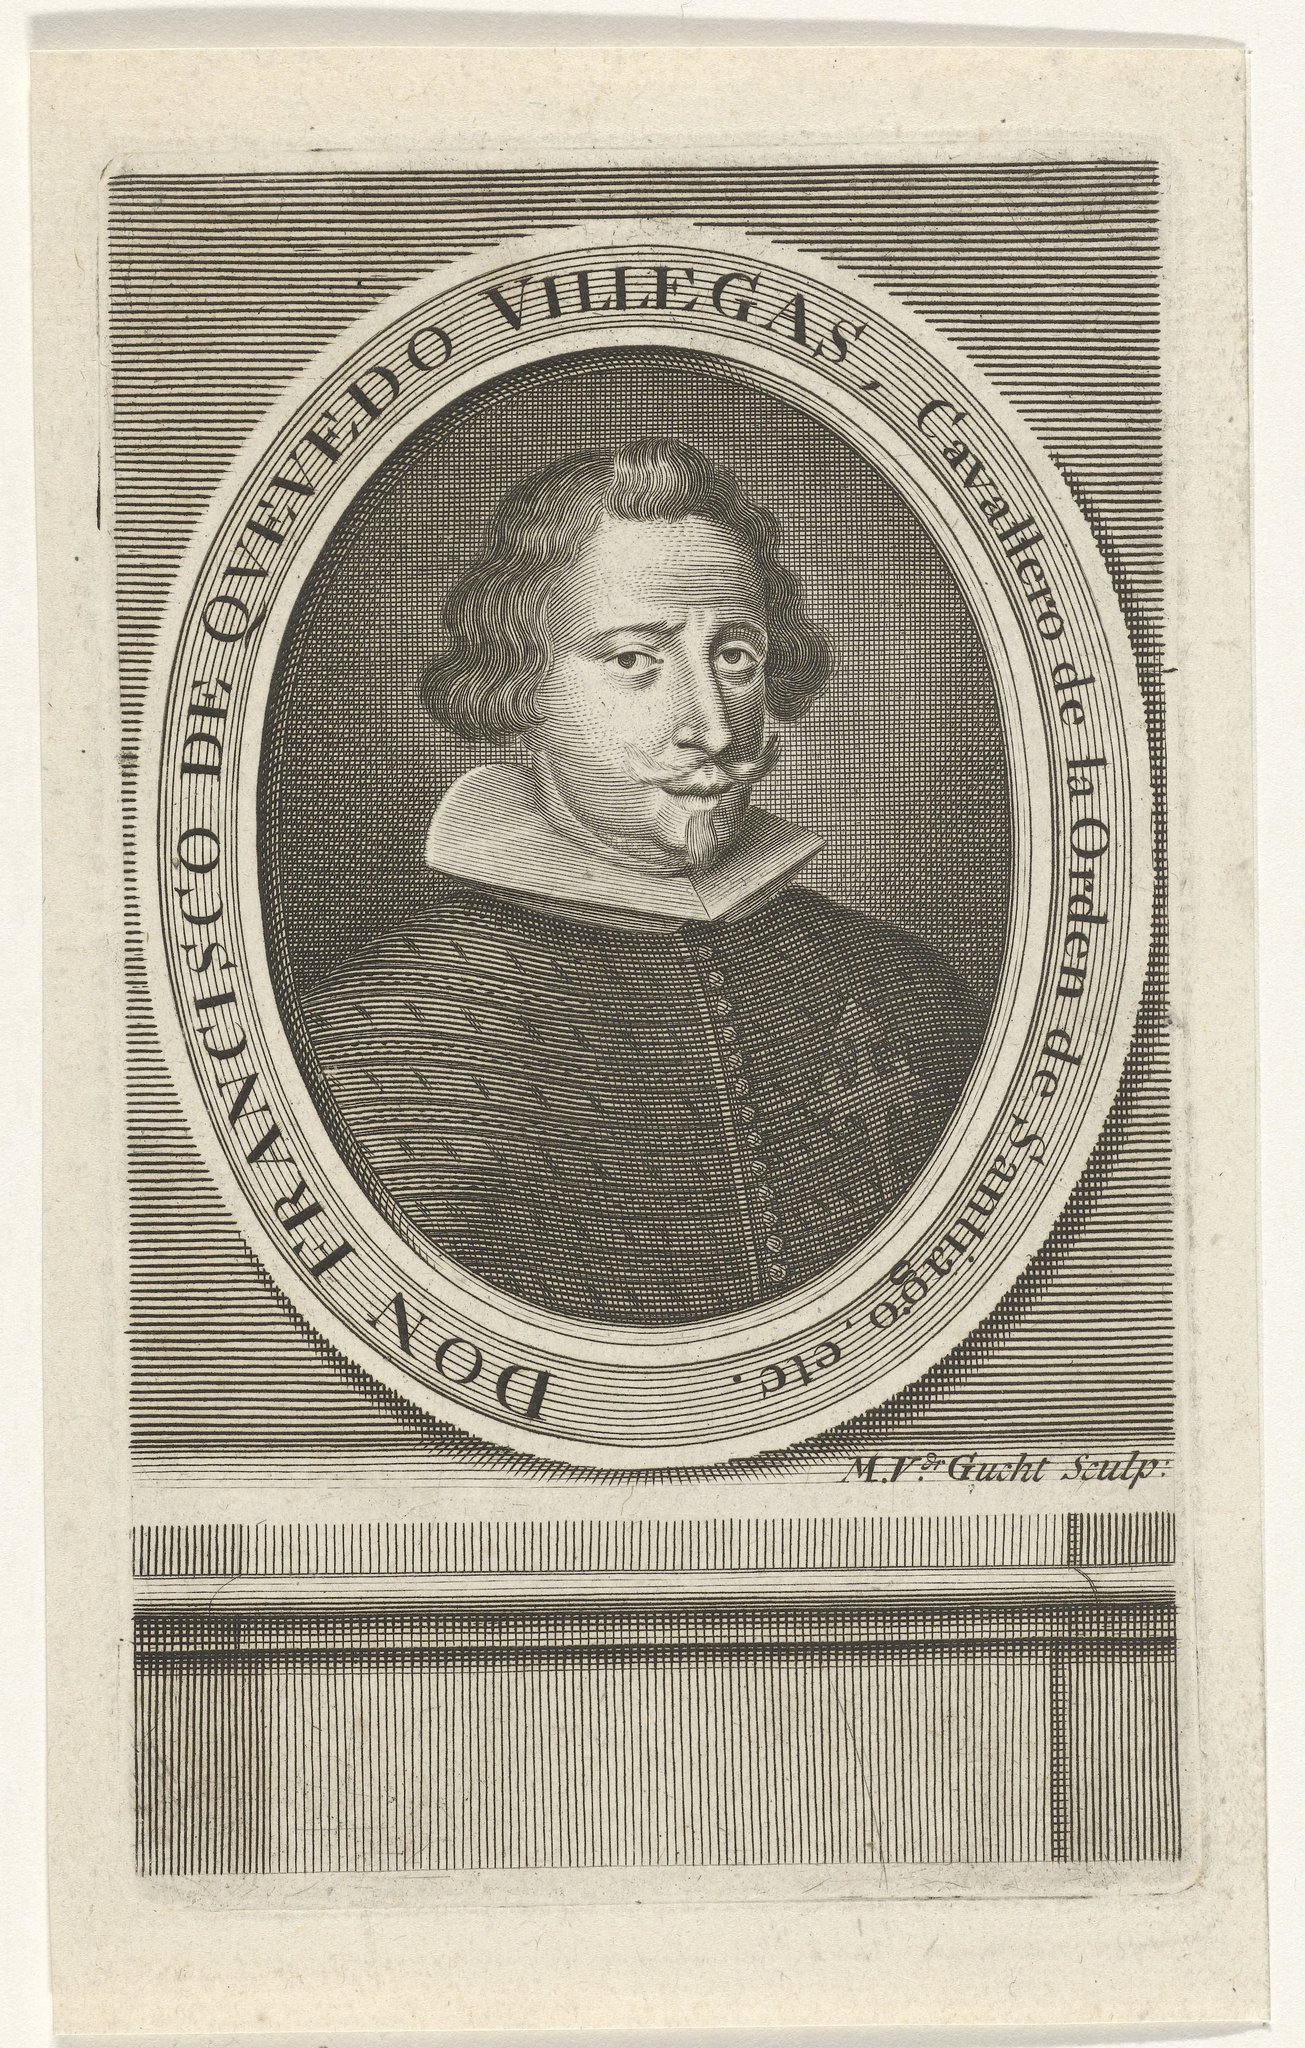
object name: print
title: Portret van Don Francisco de Quevedo Villegas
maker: michiel van der gucht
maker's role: print maker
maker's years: 1660-1725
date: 1670-1725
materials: paper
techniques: engraving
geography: antwerp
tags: armour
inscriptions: inscription: Lugt 2228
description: Busteportret van Don Francisco de Quevedo Villegas, in harnas. Het portret is gevat in een ovale omlijsting met een randschrift in het Latijn.